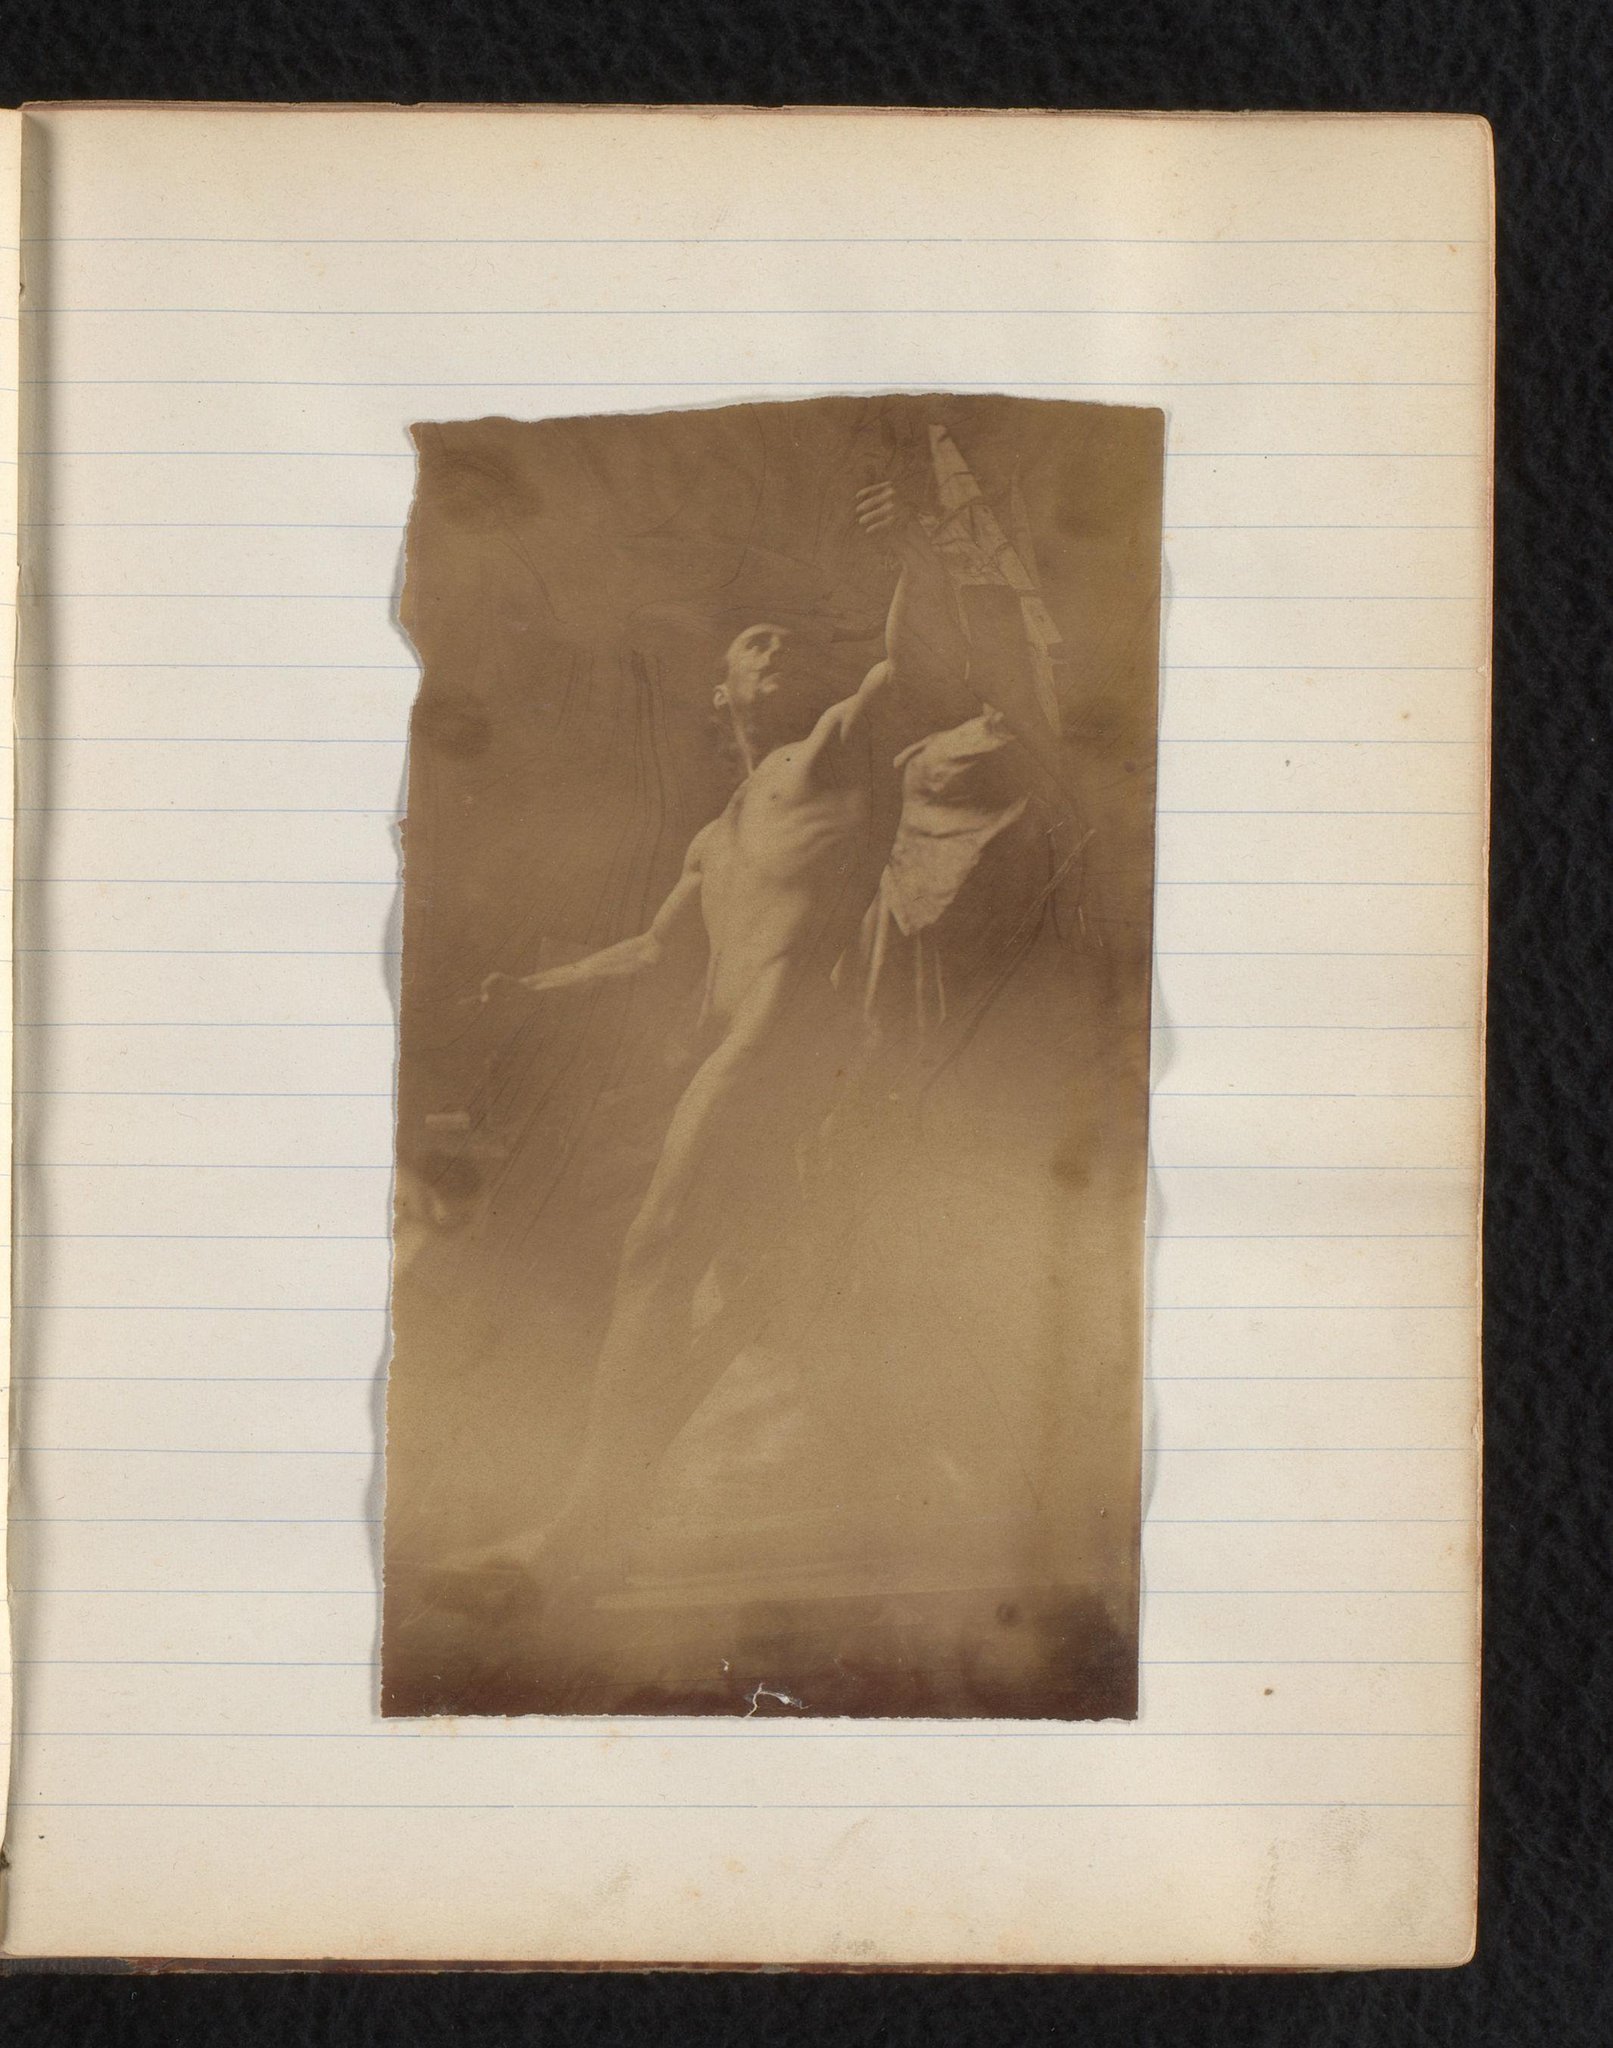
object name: photograph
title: Studie van een mannelijk naaktmodel met de hand in een stellage, van onderen gezien, in het atelier van Jacques de Lalaing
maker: jacques lalaing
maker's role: painter, sculptor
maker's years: 1858-1917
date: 1883-1914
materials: photographic support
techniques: albumen print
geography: brussels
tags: adult woman, the (nude) human figure; 'corpo humano' (ripa), artist (in general) working from nude model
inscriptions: inscription: ‘[...]’